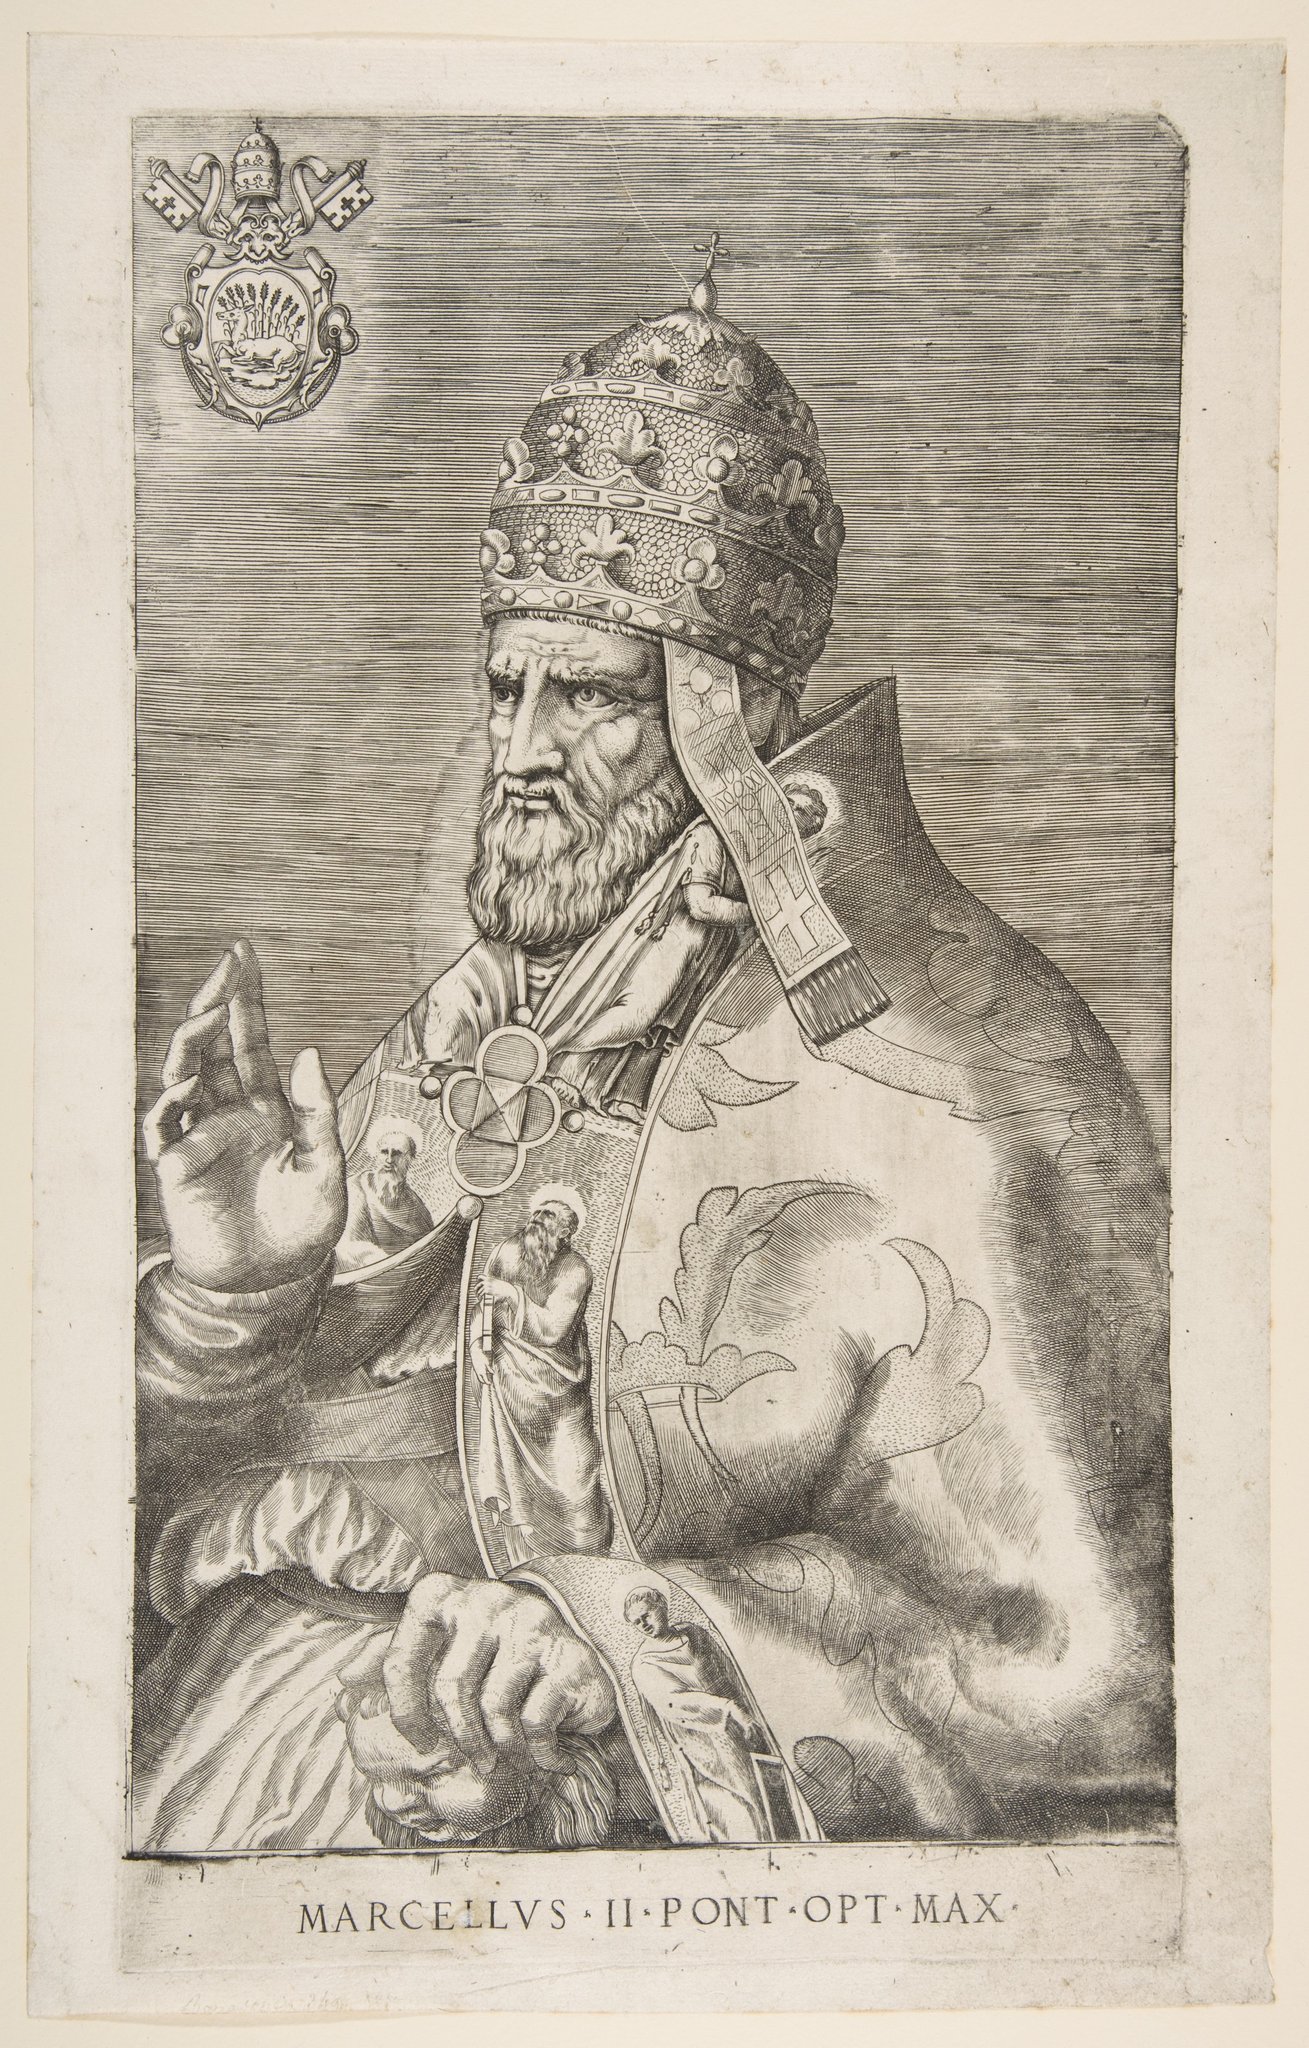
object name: print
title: Portrait of Pope Marcellus II, right hand raised facing left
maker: giulio bonasone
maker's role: artist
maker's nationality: italian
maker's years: 1510-1576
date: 1555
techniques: engraving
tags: men,portraits,popes,coat of arms